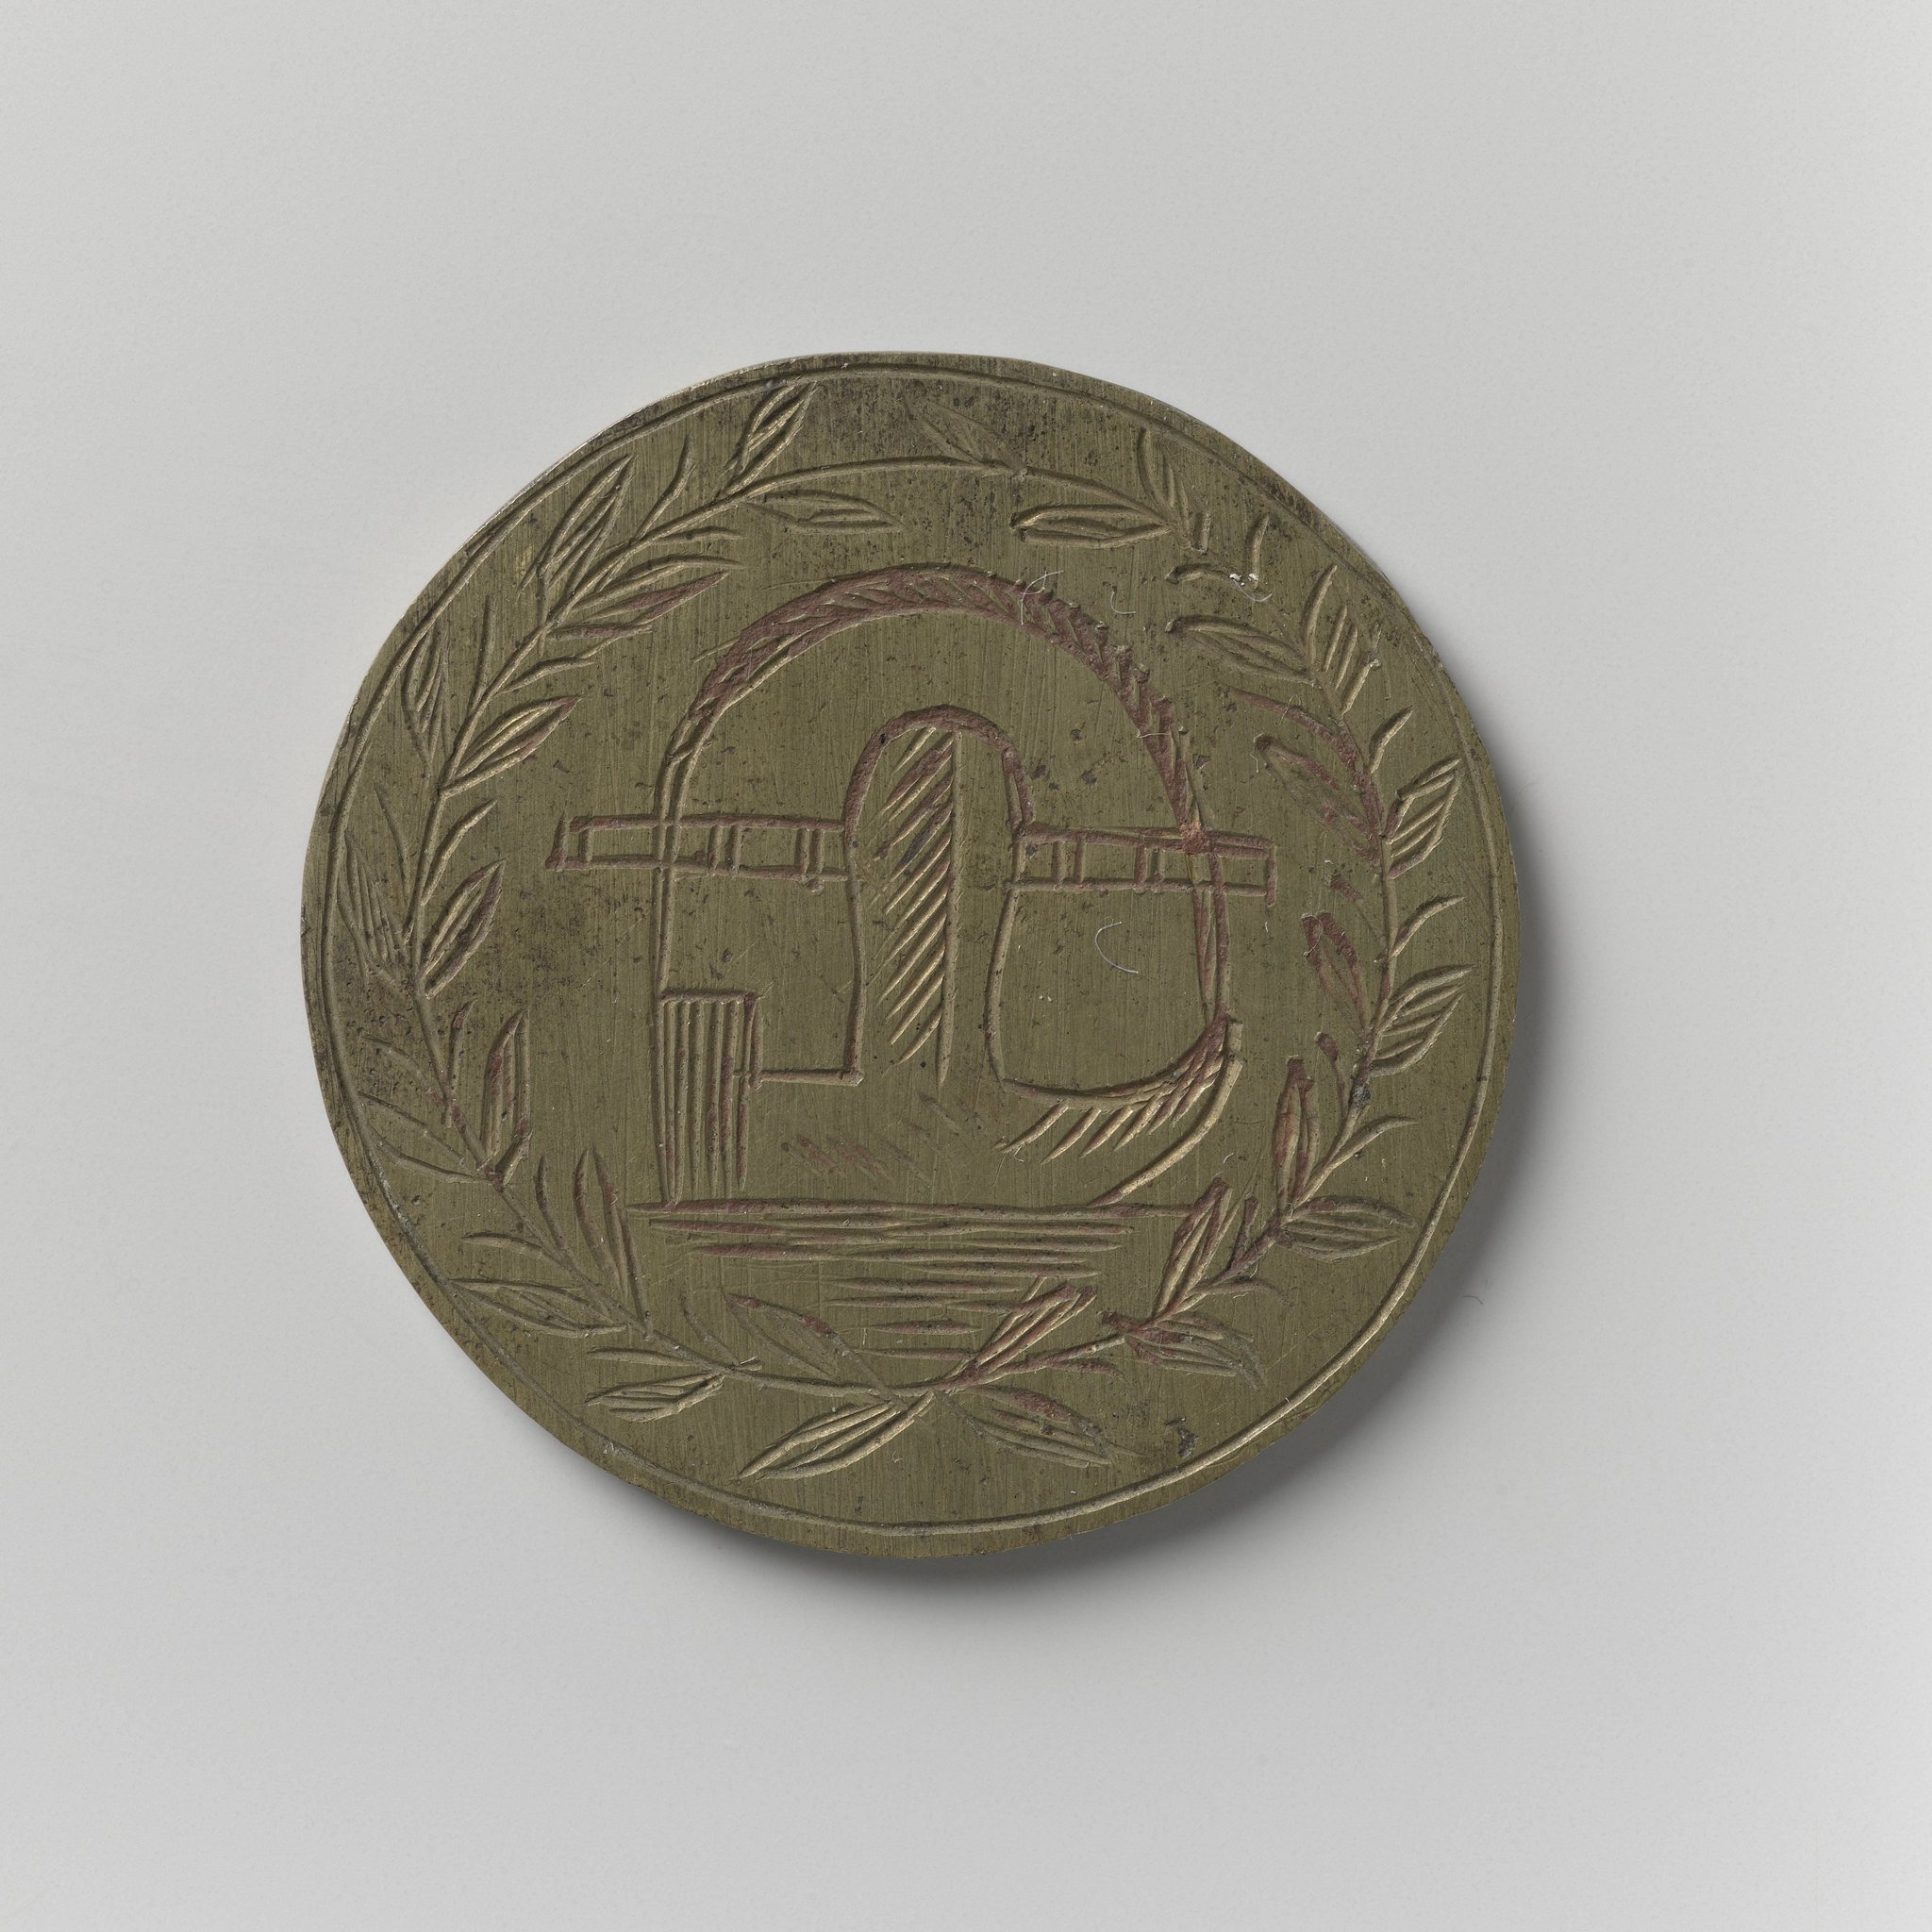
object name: medal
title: Kuipers- en wijnverlatersgilde van Amsterdam, gildepenning van Hendrik van Veen, meester kuiper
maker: Anonymous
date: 1802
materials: brass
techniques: engraving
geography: amsterdam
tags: amsterdam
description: Messing penning. Voorzijde: dissel en passer binnen bladerkrans. Keerzijde: opschrift